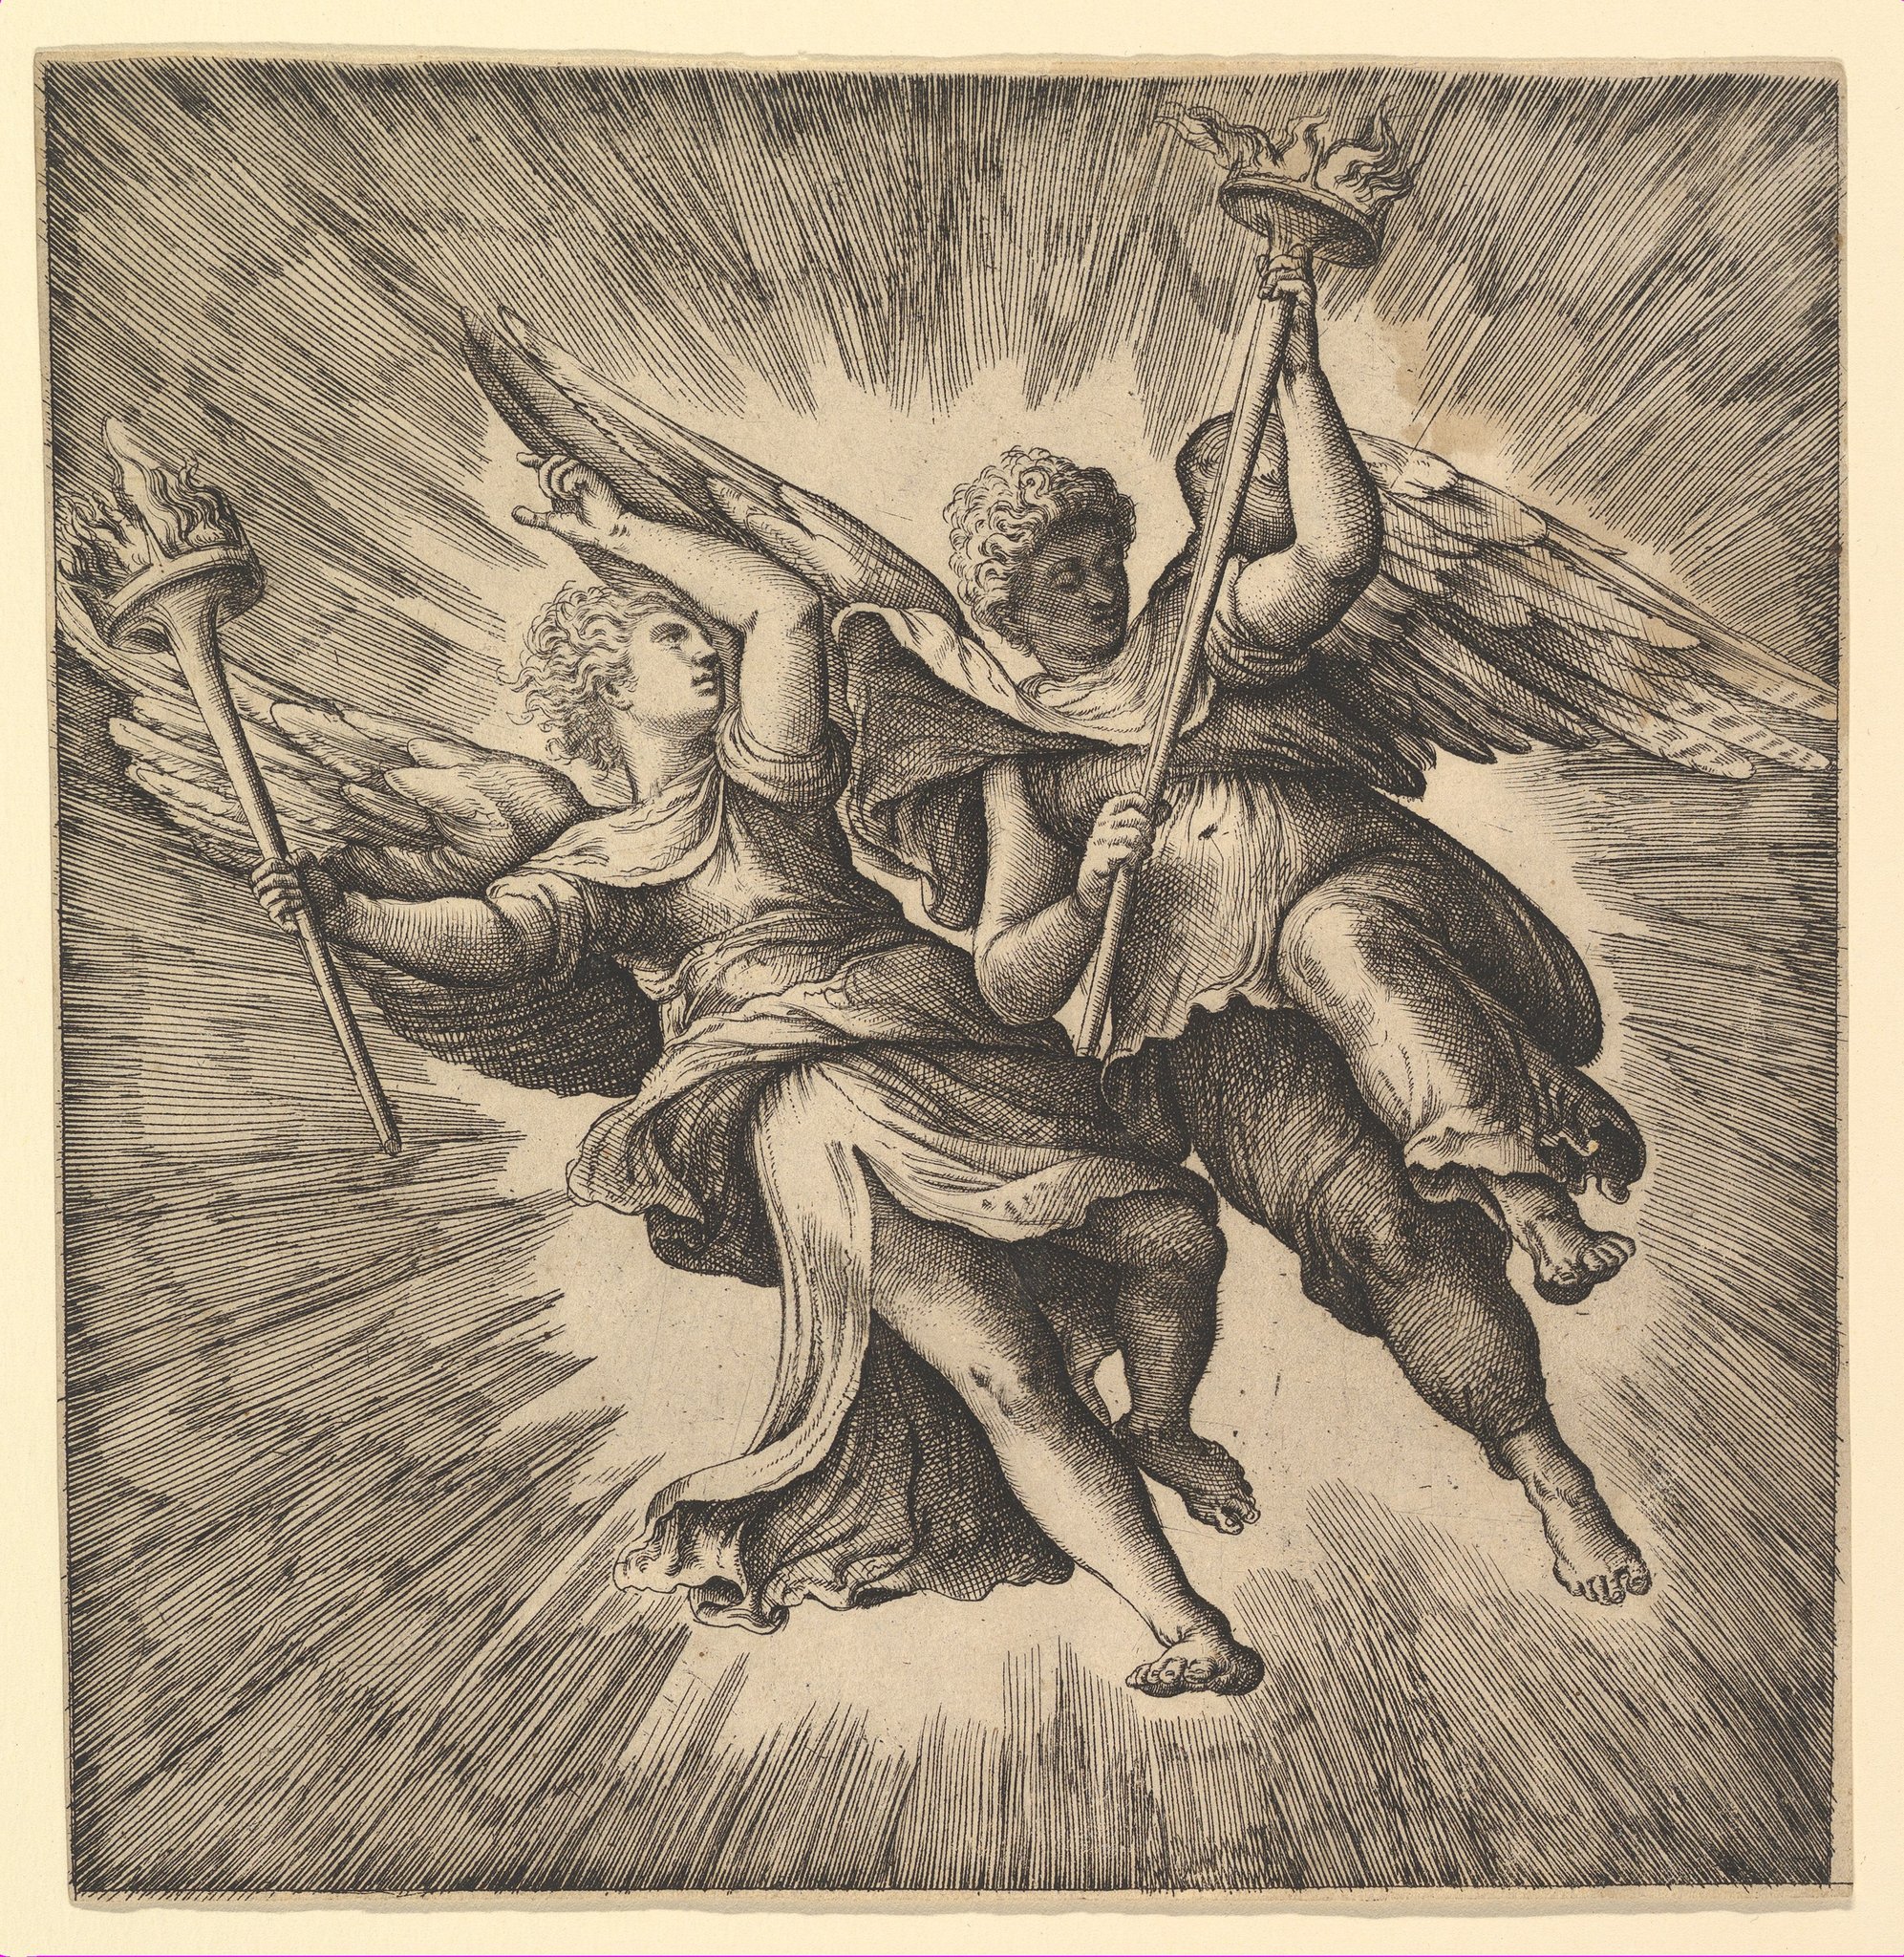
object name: print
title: Two Angels or Winged Genii Carrying Torches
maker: battista franco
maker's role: artist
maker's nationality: italian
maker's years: 1510-1561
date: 1510-1561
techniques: engraving, etching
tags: angels